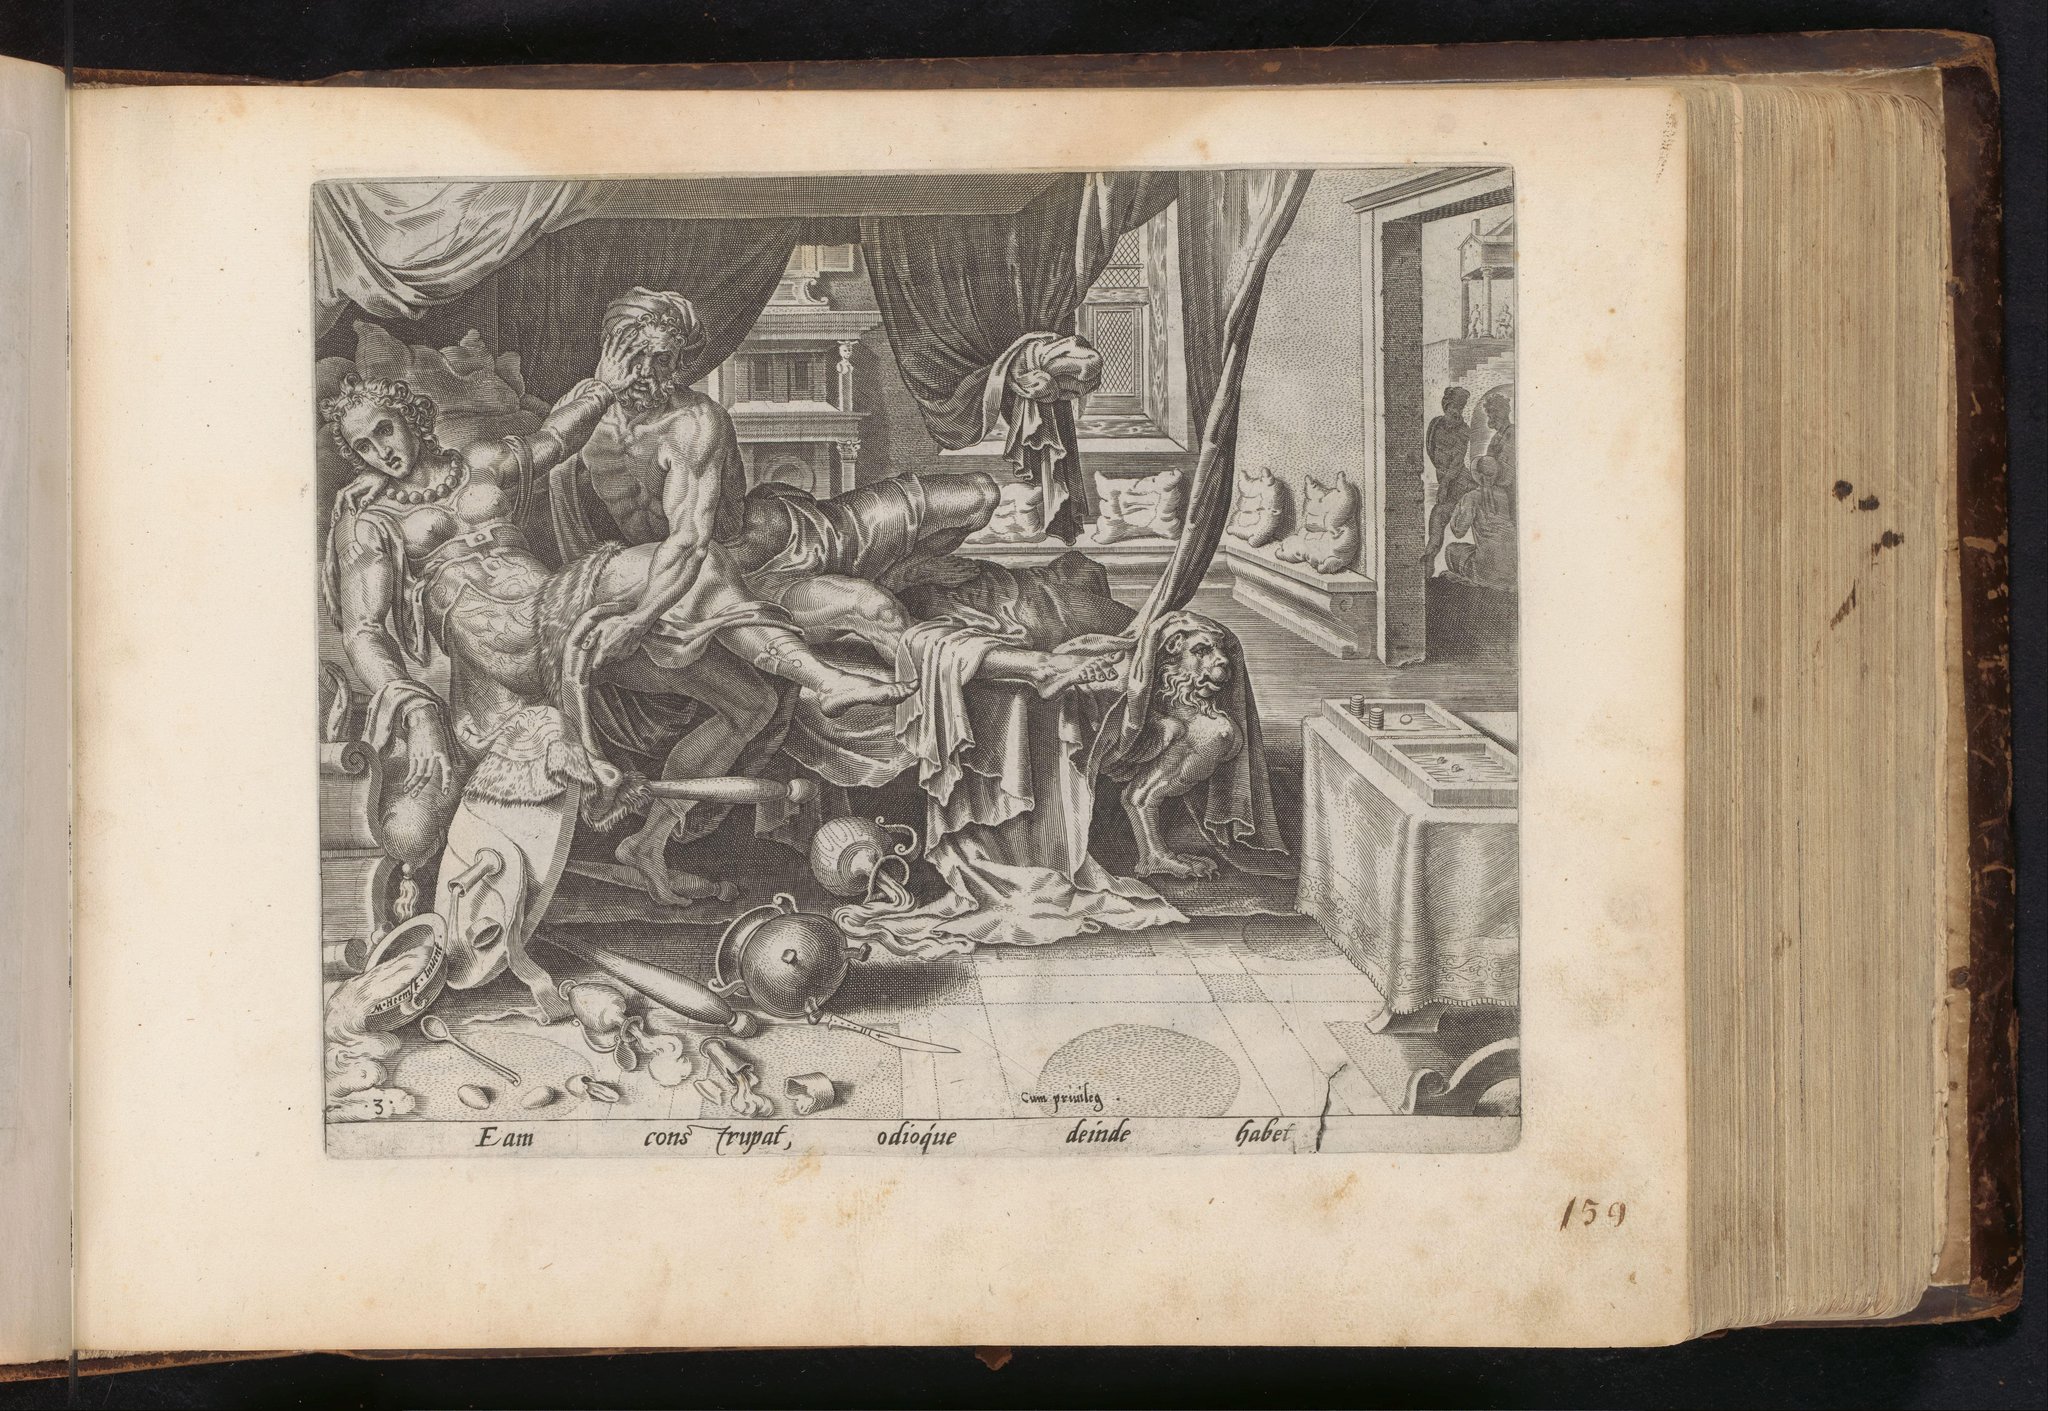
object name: album leaf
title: Van Ammon en Thamer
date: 1559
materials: paper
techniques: engraving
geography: alkmaar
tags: tamar violated by amnon, backgammon, tric-trac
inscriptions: number: ‘159’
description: Amnon pretendeert dat hij ziek op bed ligt en laat zijn halfzus Tamar eten brengen. Hij trekt haar op bed om haar te verkrachten. Tamar protesteert en probeert hem te weerhouden. De tafel met eten valt om. Onder de voorstelling een verwijzing in het Latijn naar de Bijbeltekst. Prent maakt deel uit van een album.